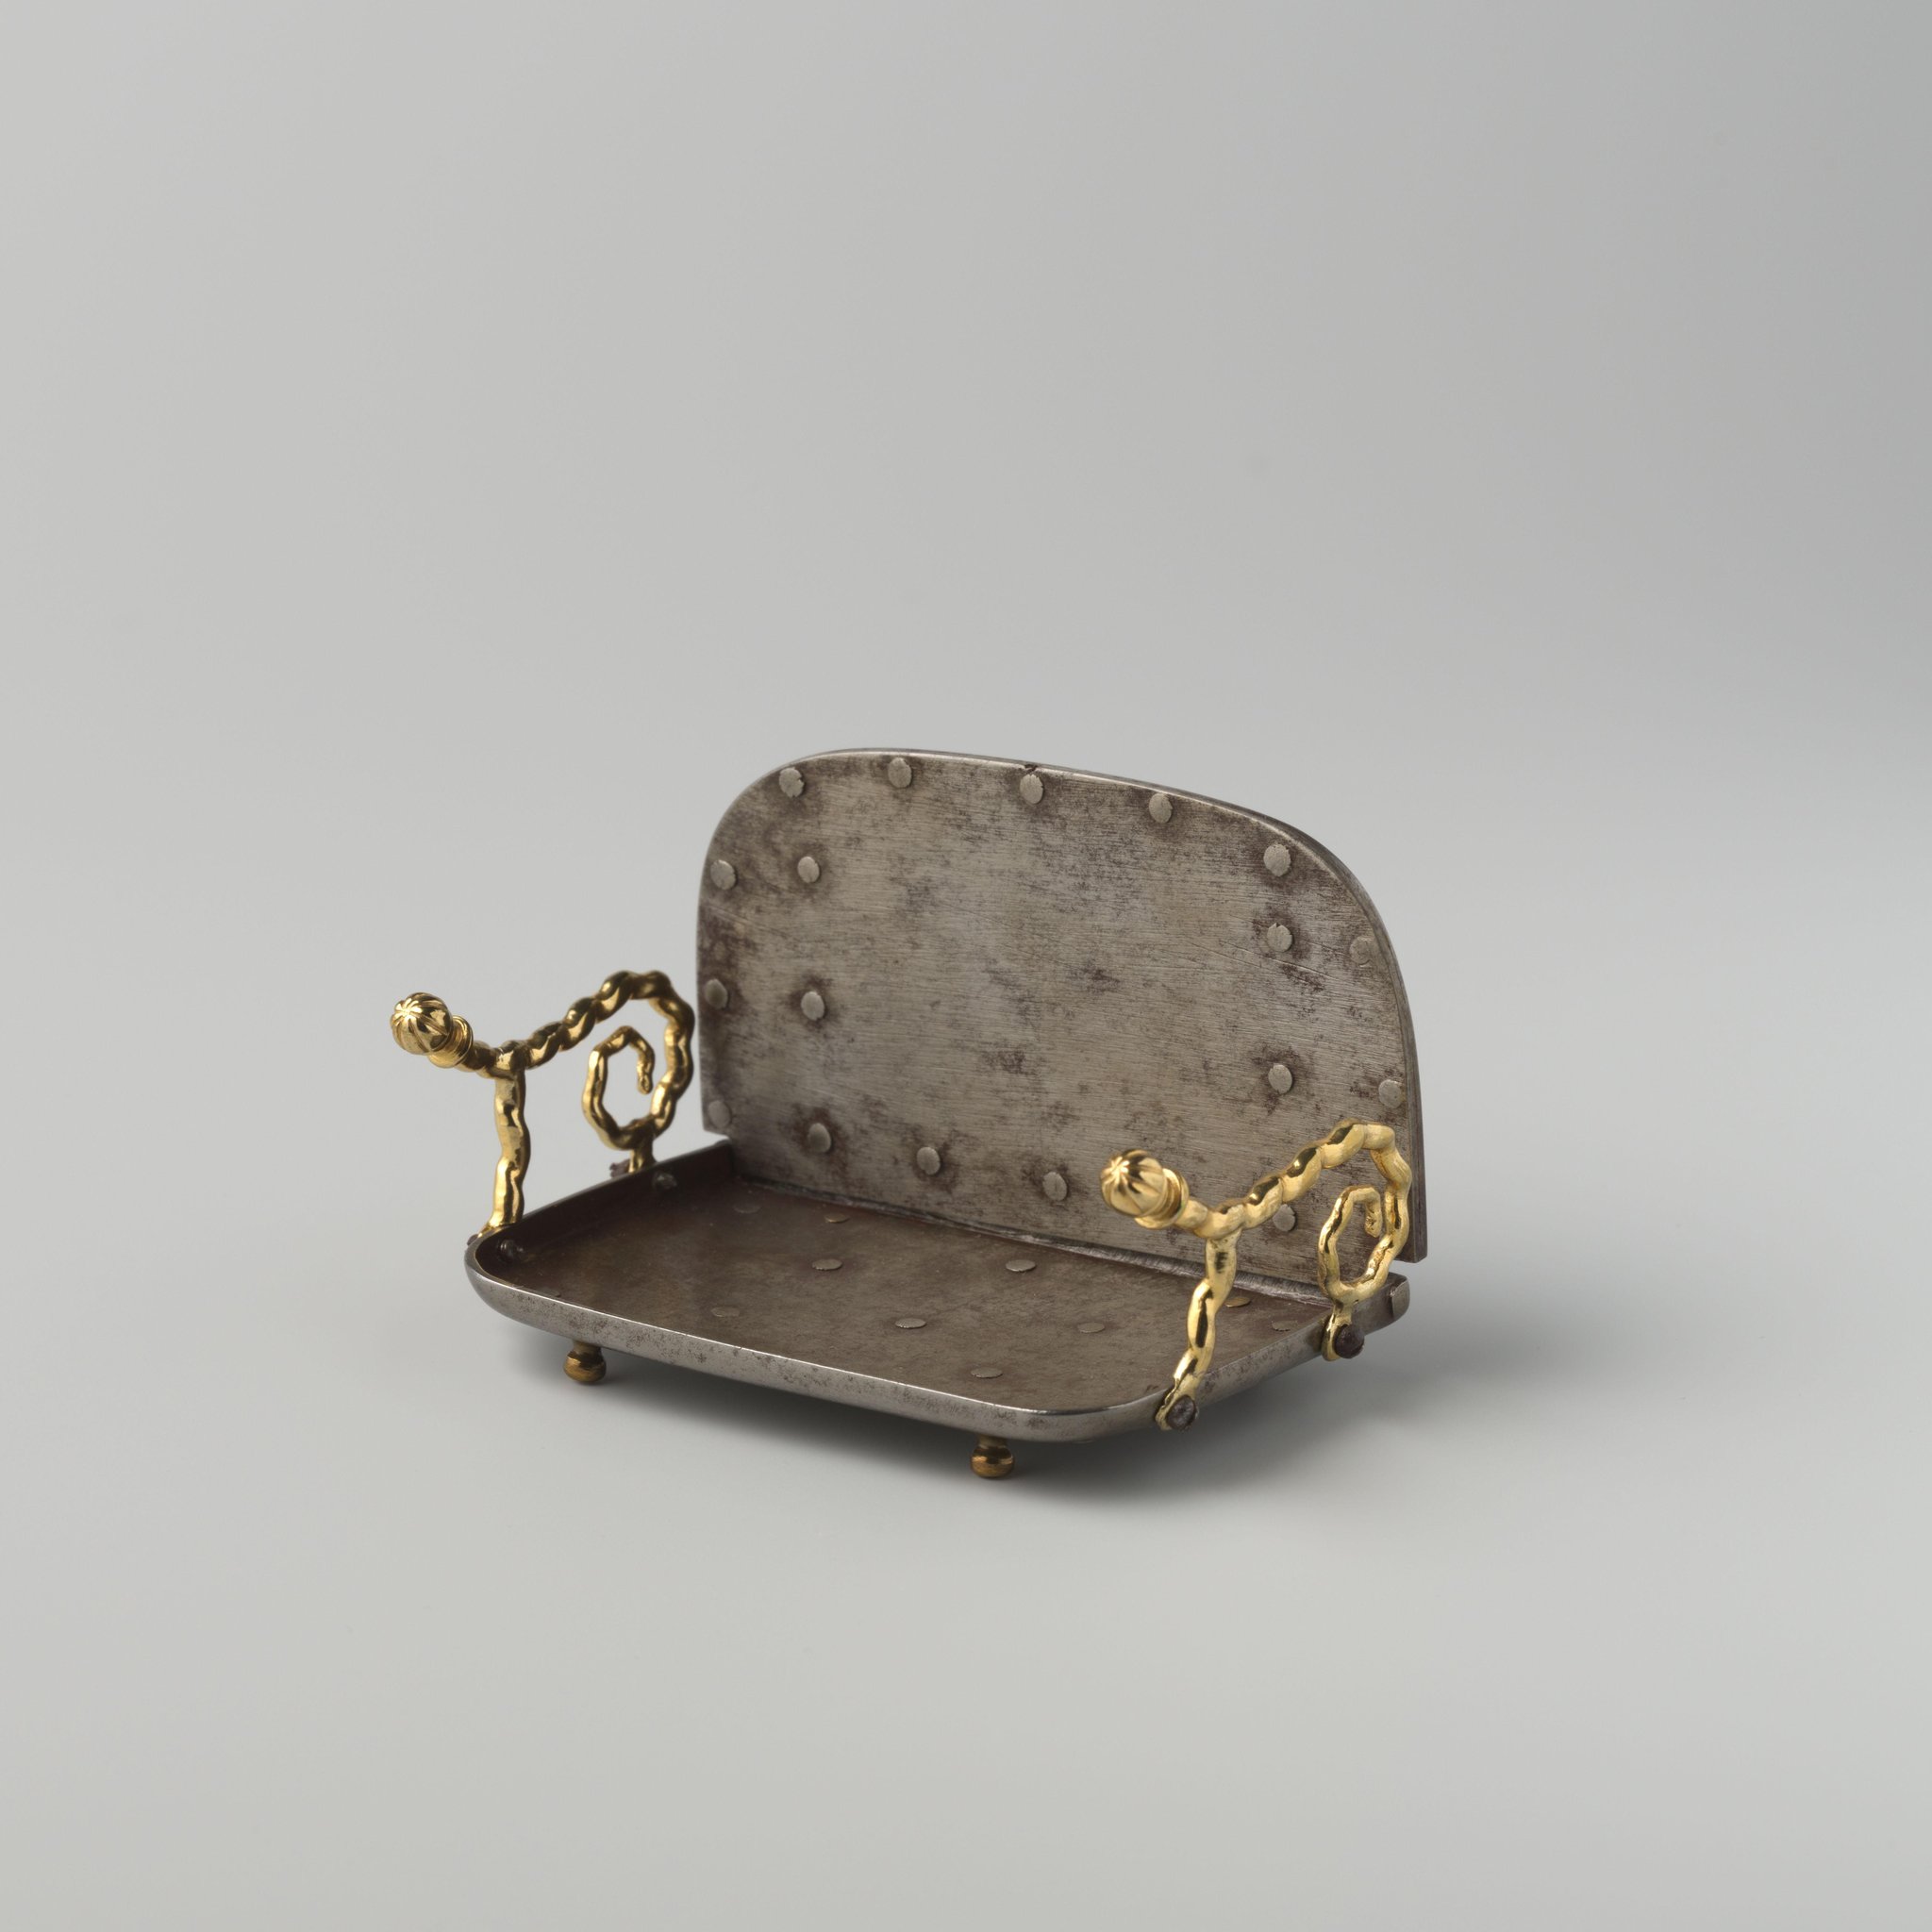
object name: vuurbok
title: Vuurbak van smeedijzer met koperen wangen en bolpoten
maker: Anonymous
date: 1690-1710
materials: copper, iron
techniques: gilding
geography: amsterdam